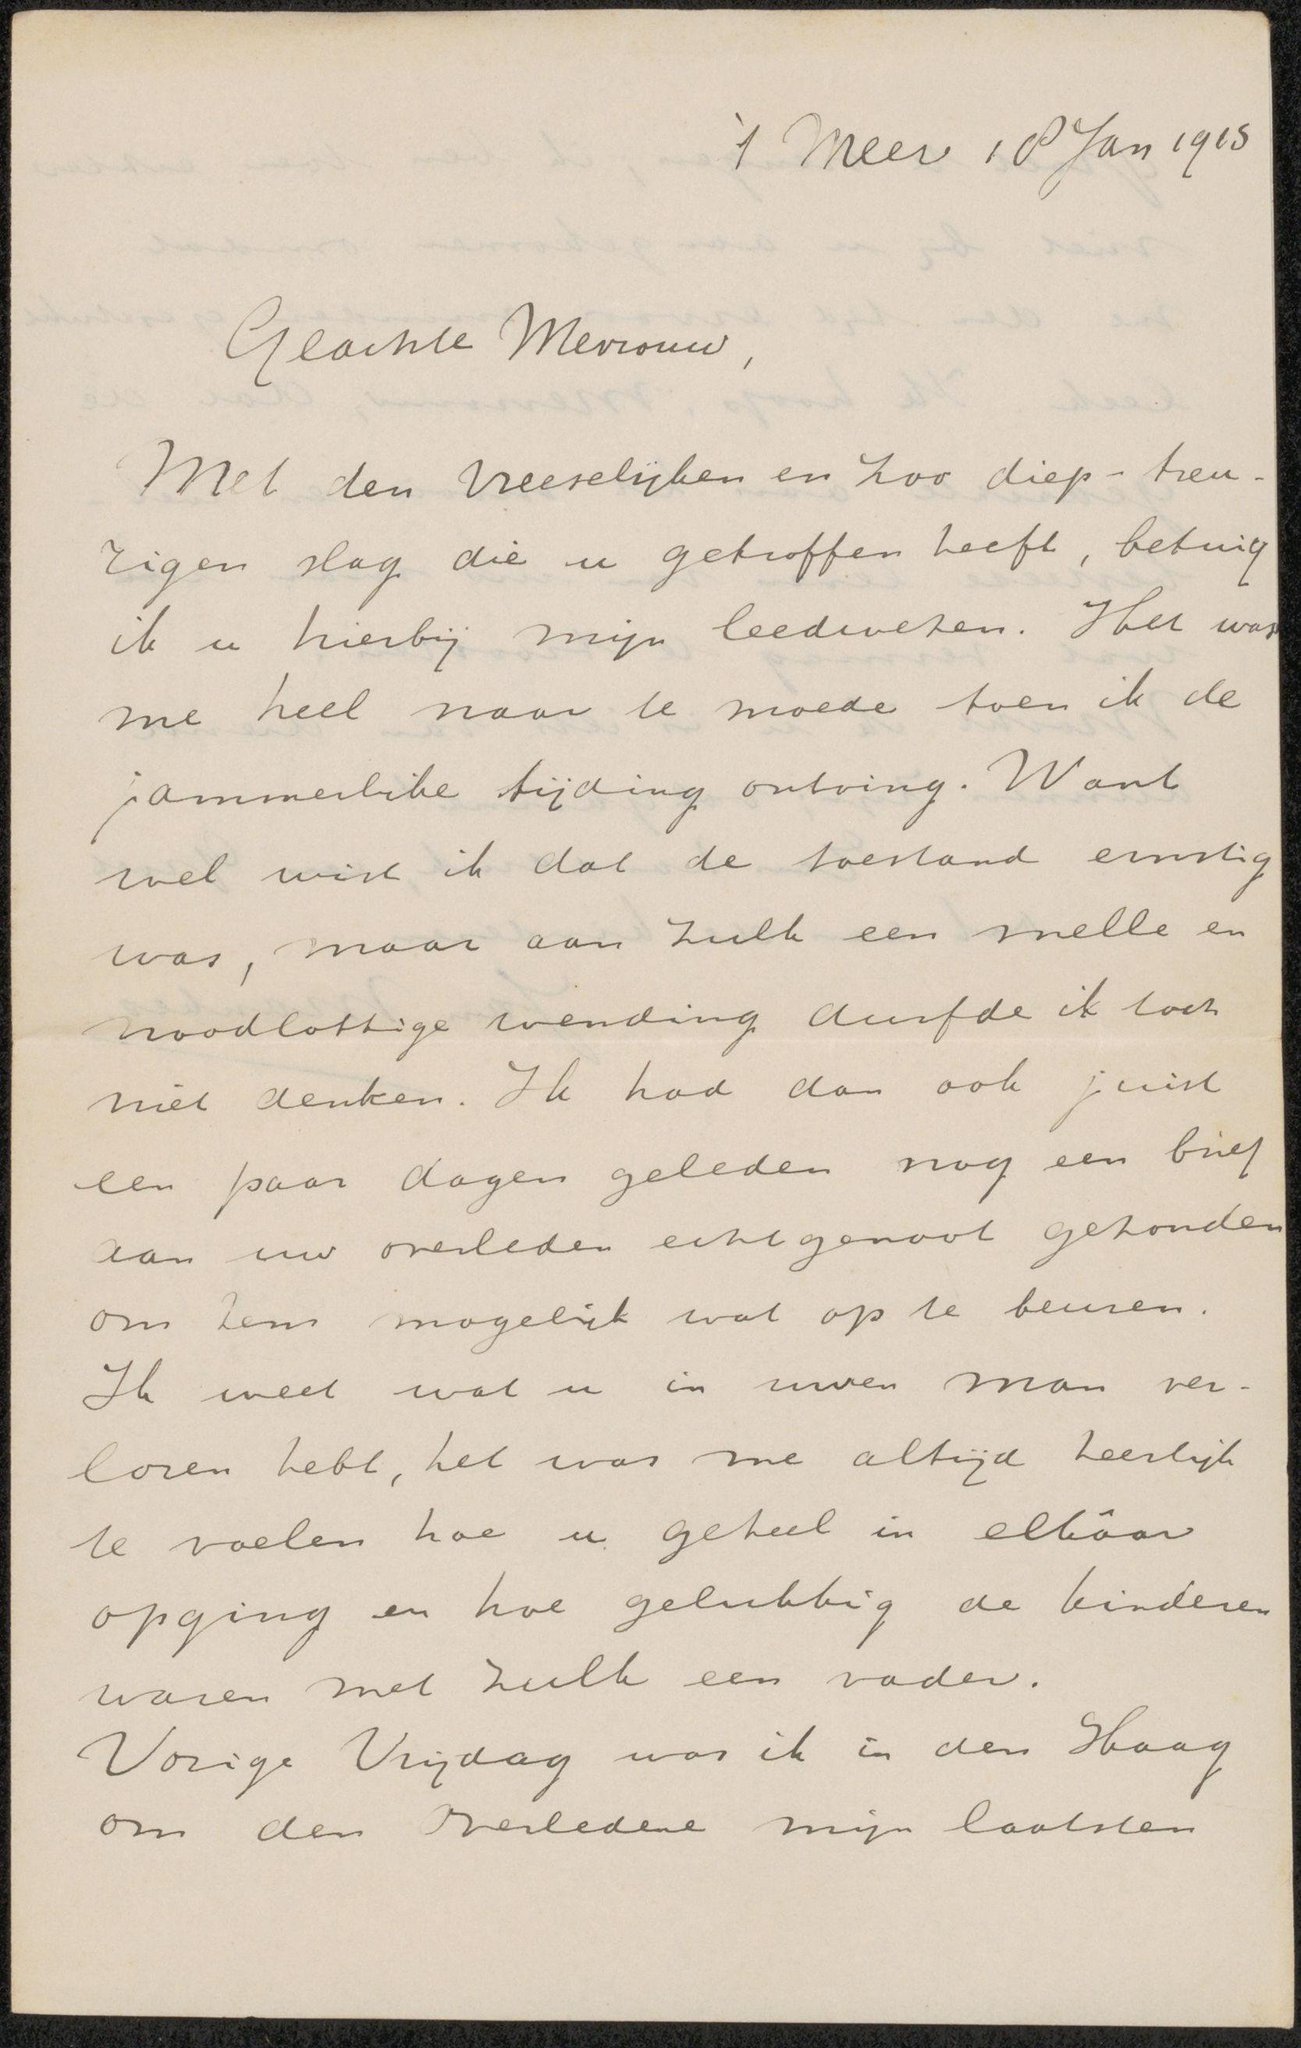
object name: letter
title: Brief aan E.H. Schüller-Audretsch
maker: jan mankes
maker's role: draughtsman, painter, print maker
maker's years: 1889-1920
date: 1915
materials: ink, paper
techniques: pen, writing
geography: het meer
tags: painter, print maker, draughtsman, jan schüller, family life, the hague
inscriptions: watermark